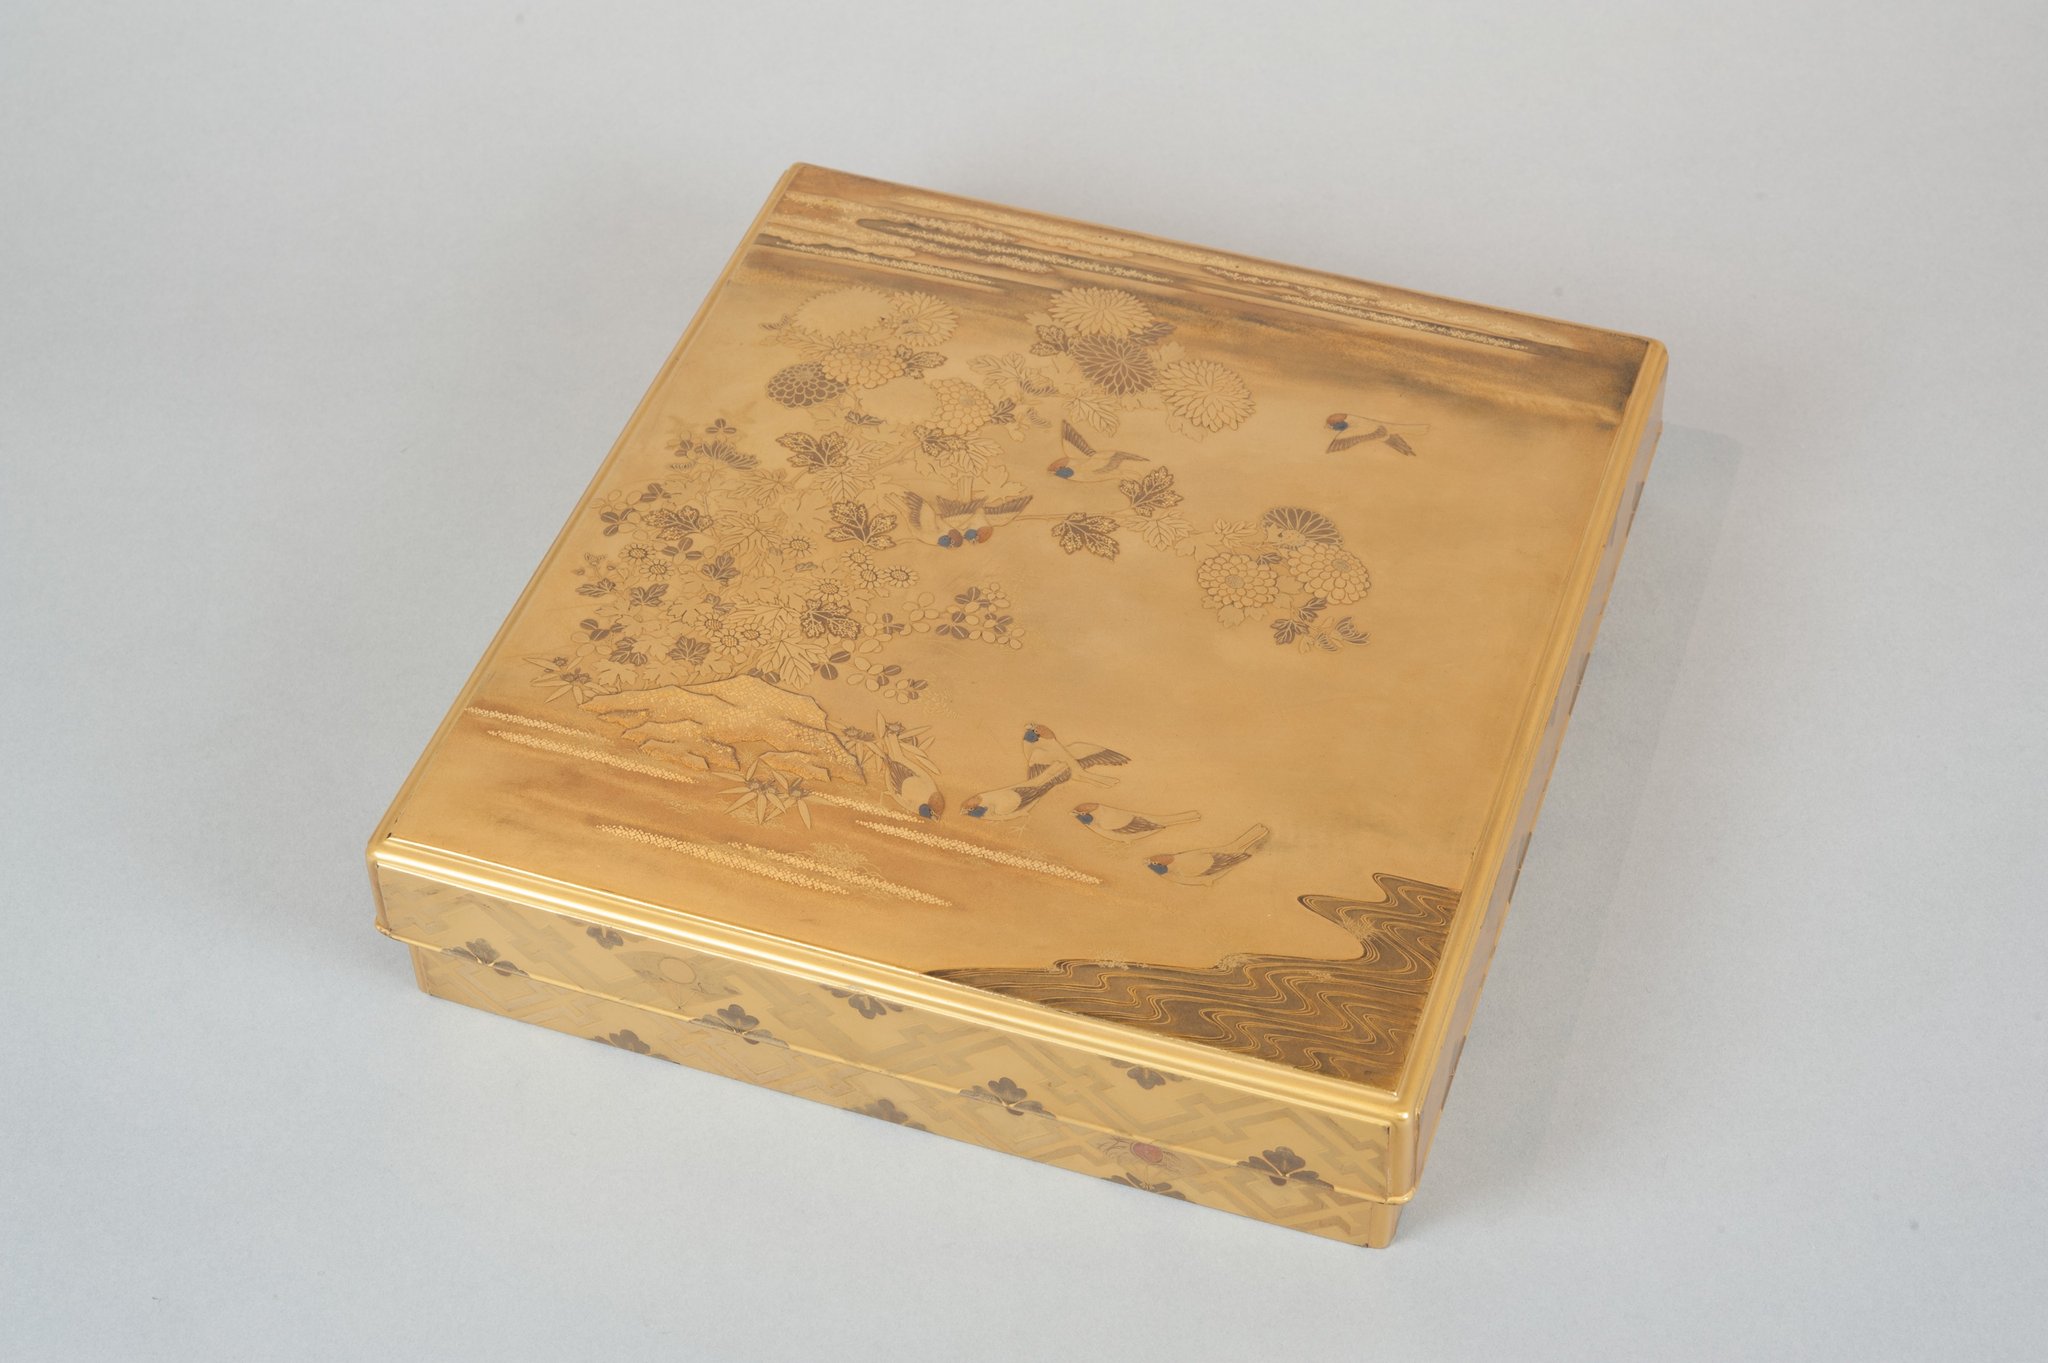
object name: writing box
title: Writing Box with Design of the Tatsuta River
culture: japanese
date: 1801-1900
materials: gold, lacquer, silver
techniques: maki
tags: birds,rivers,flowers